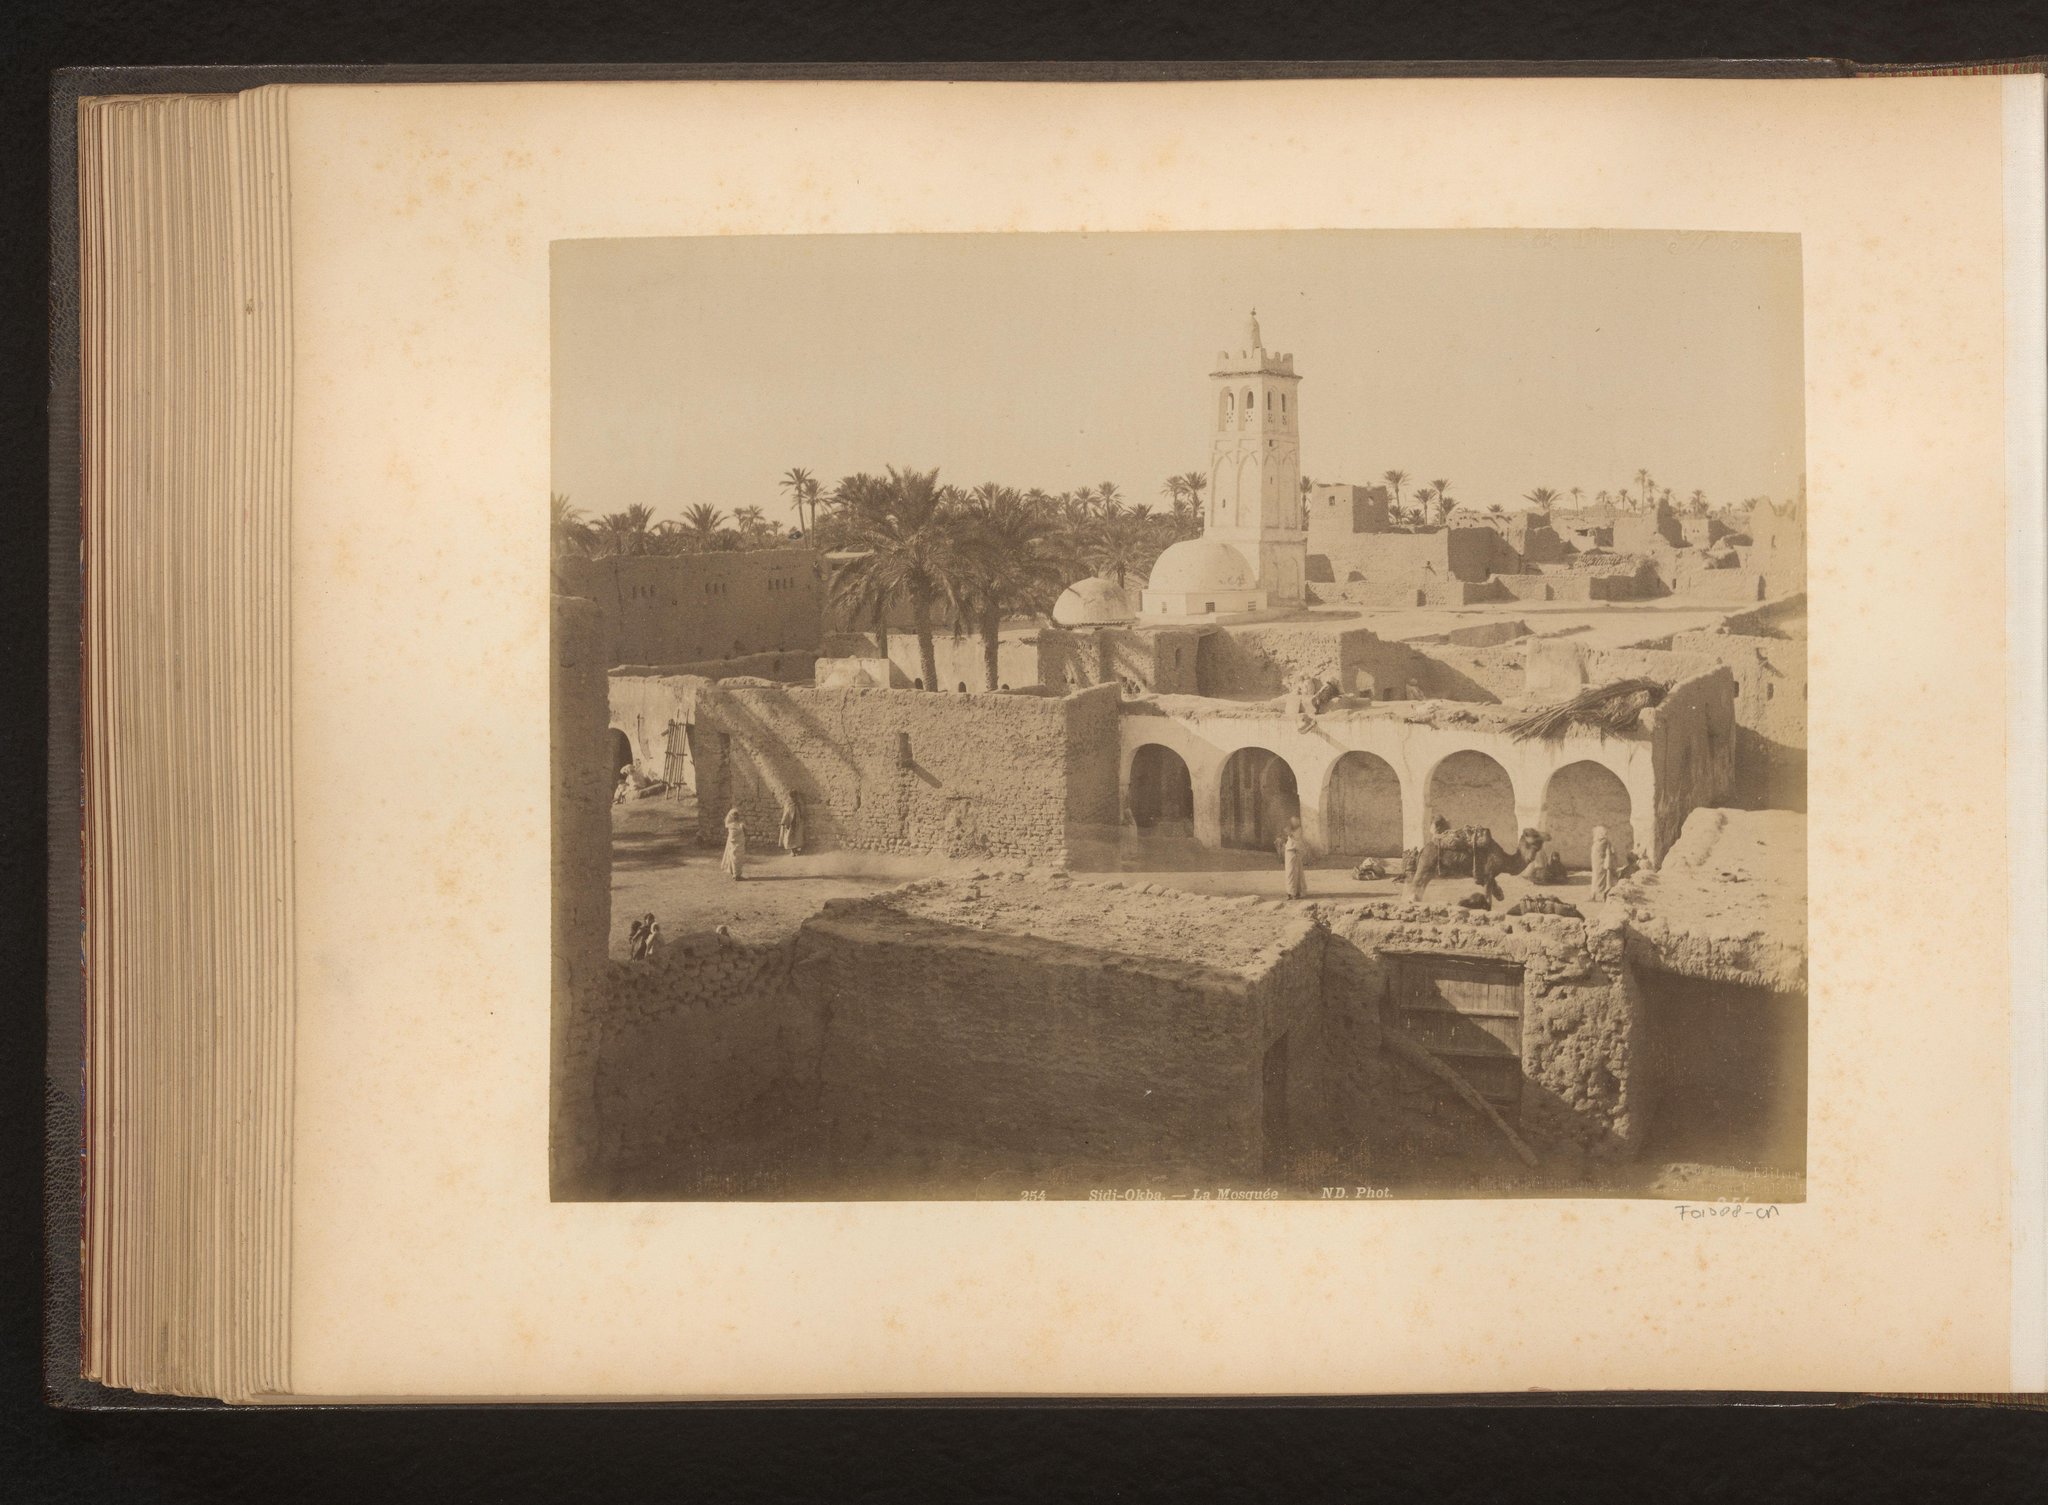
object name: photograph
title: Sidi-Okba. - La Mosquee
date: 1880-1900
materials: photographic support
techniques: albumen print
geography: algeria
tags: temple, shrine ~ islam, mohammedanism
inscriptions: number: ‘[...]’, check stamp: ‘J. Kuhn Editeur/ 220 Rue de Rivoli Paris’